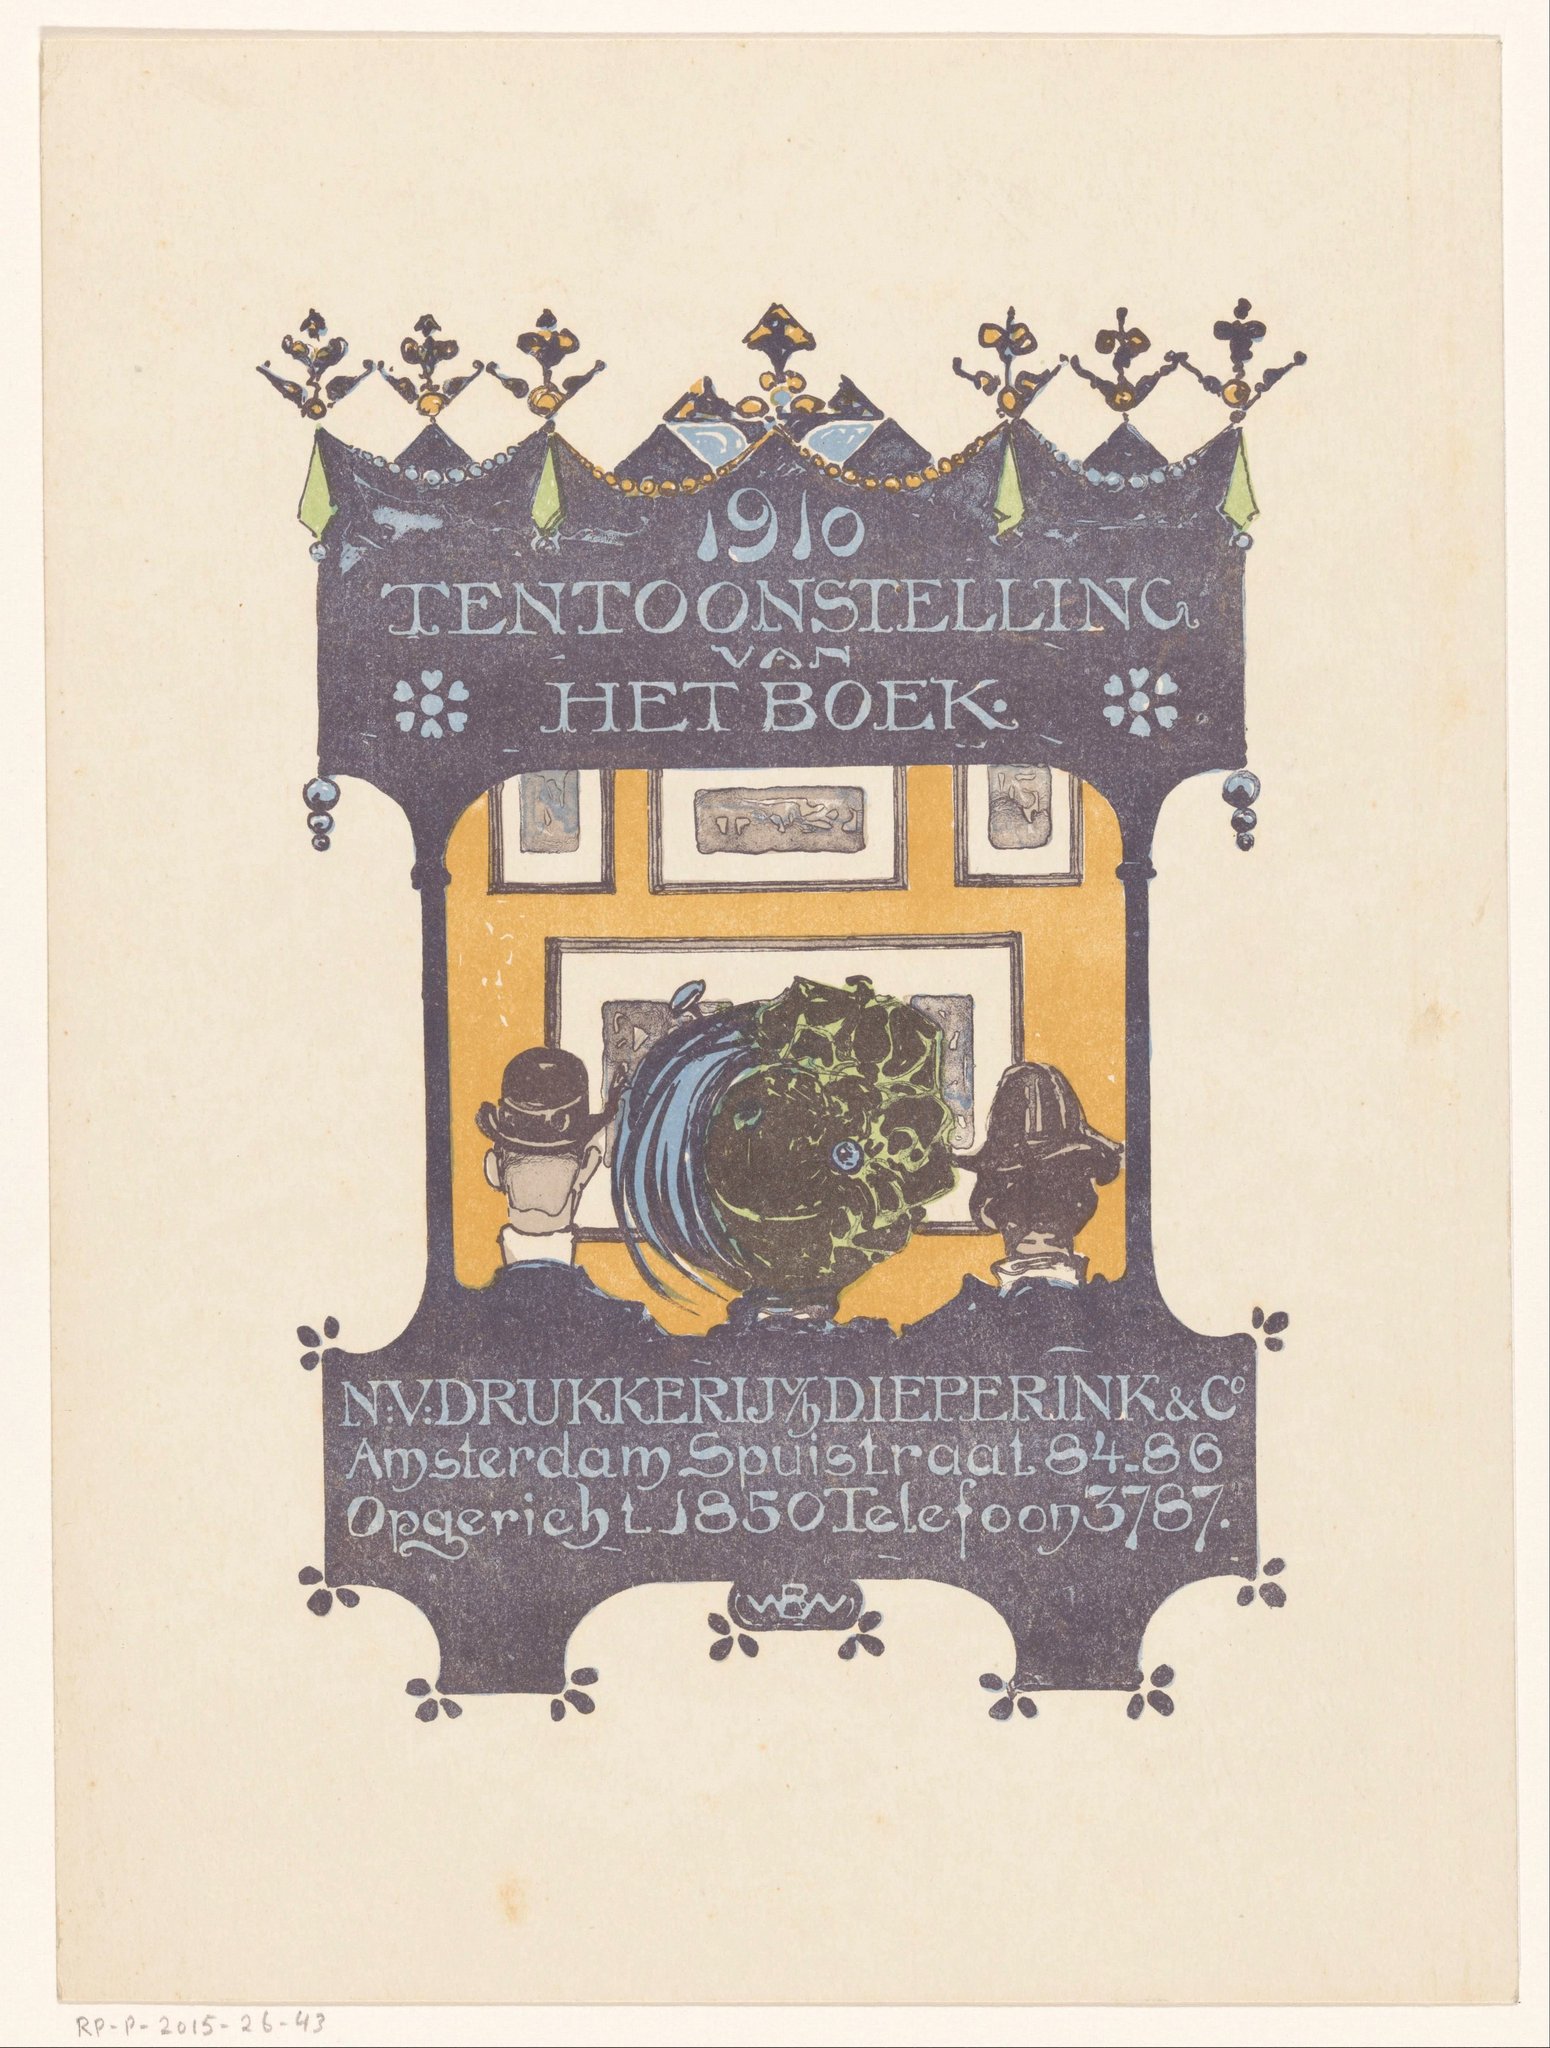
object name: print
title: Advertentie van de Amsterdamse steen- en boekdrukkerij Dieperink & Co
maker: bernard willem wierink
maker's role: draughtsman, print maker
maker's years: 1856-1939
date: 1910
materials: paper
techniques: lithograph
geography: amsterdam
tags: art collection, art gallery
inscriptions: collector's mark: Lugt 4779, collector's mark: Lugt 2228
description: Prent gebruikt in: Nijhoff, Wouter. Catalogus der Nationale tentoonstelling van het boek in het Gemeente-museum te Amsterdam. Amsterdam: Gemeente-Museum, 1910.